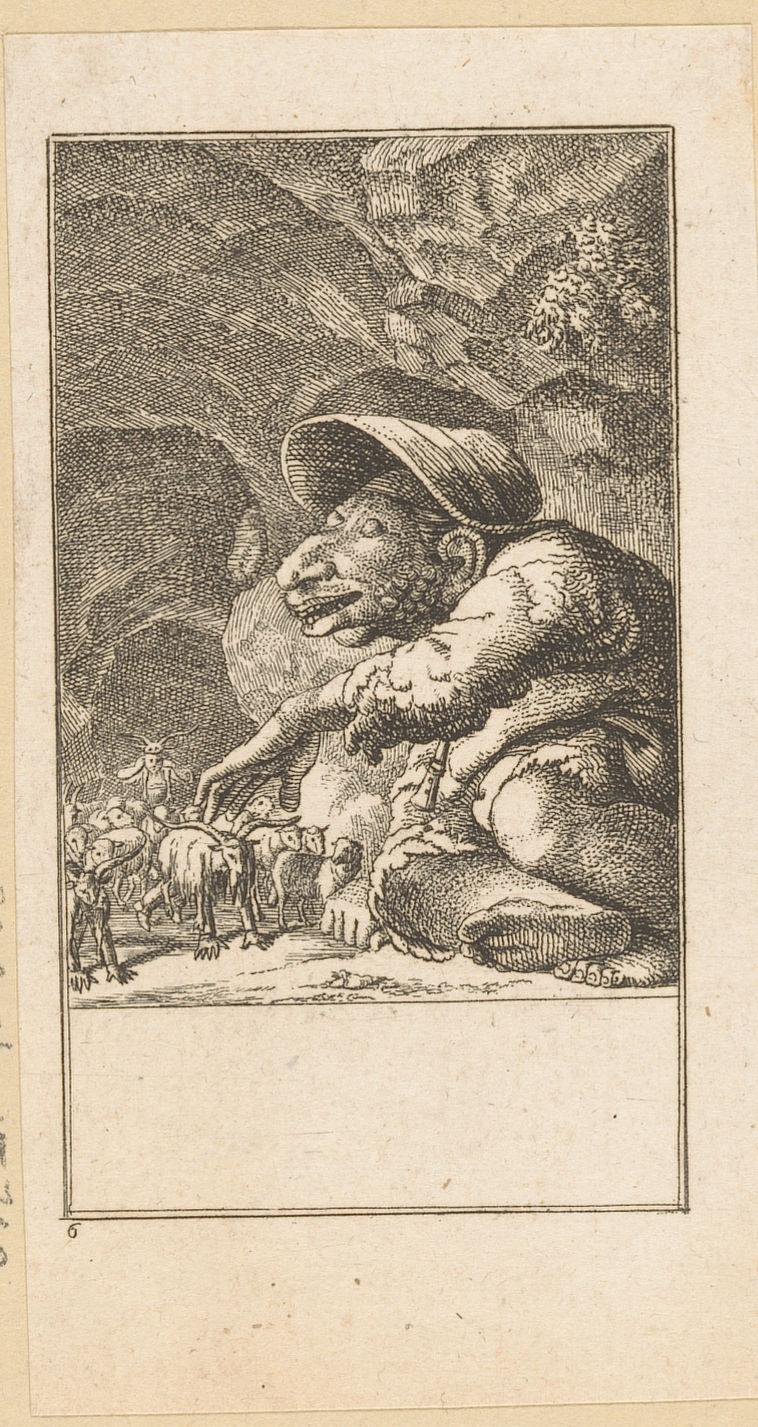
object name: print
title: Norandino en Lucina worden ontdekt door de oger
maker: louis wilhelm chodowiecki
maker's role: print maker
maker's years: 1765-1805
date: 1771-1772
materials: paper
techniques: etching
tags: male literary characters (norandino), herding, herdsman, herdswoman, shepherd, shepherdess, cowherd, etc., lucina, man disguised as animal, (scenes from) specific works of literature: ariosto, orlando furioso, giants, colossi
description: Vervaardigd voor Orlando Furioso van Ludovico Ariosto. Prent gebruikt voor: Almanac Genealogique pour l'année 1772. Berlijn: s.n.s.a.